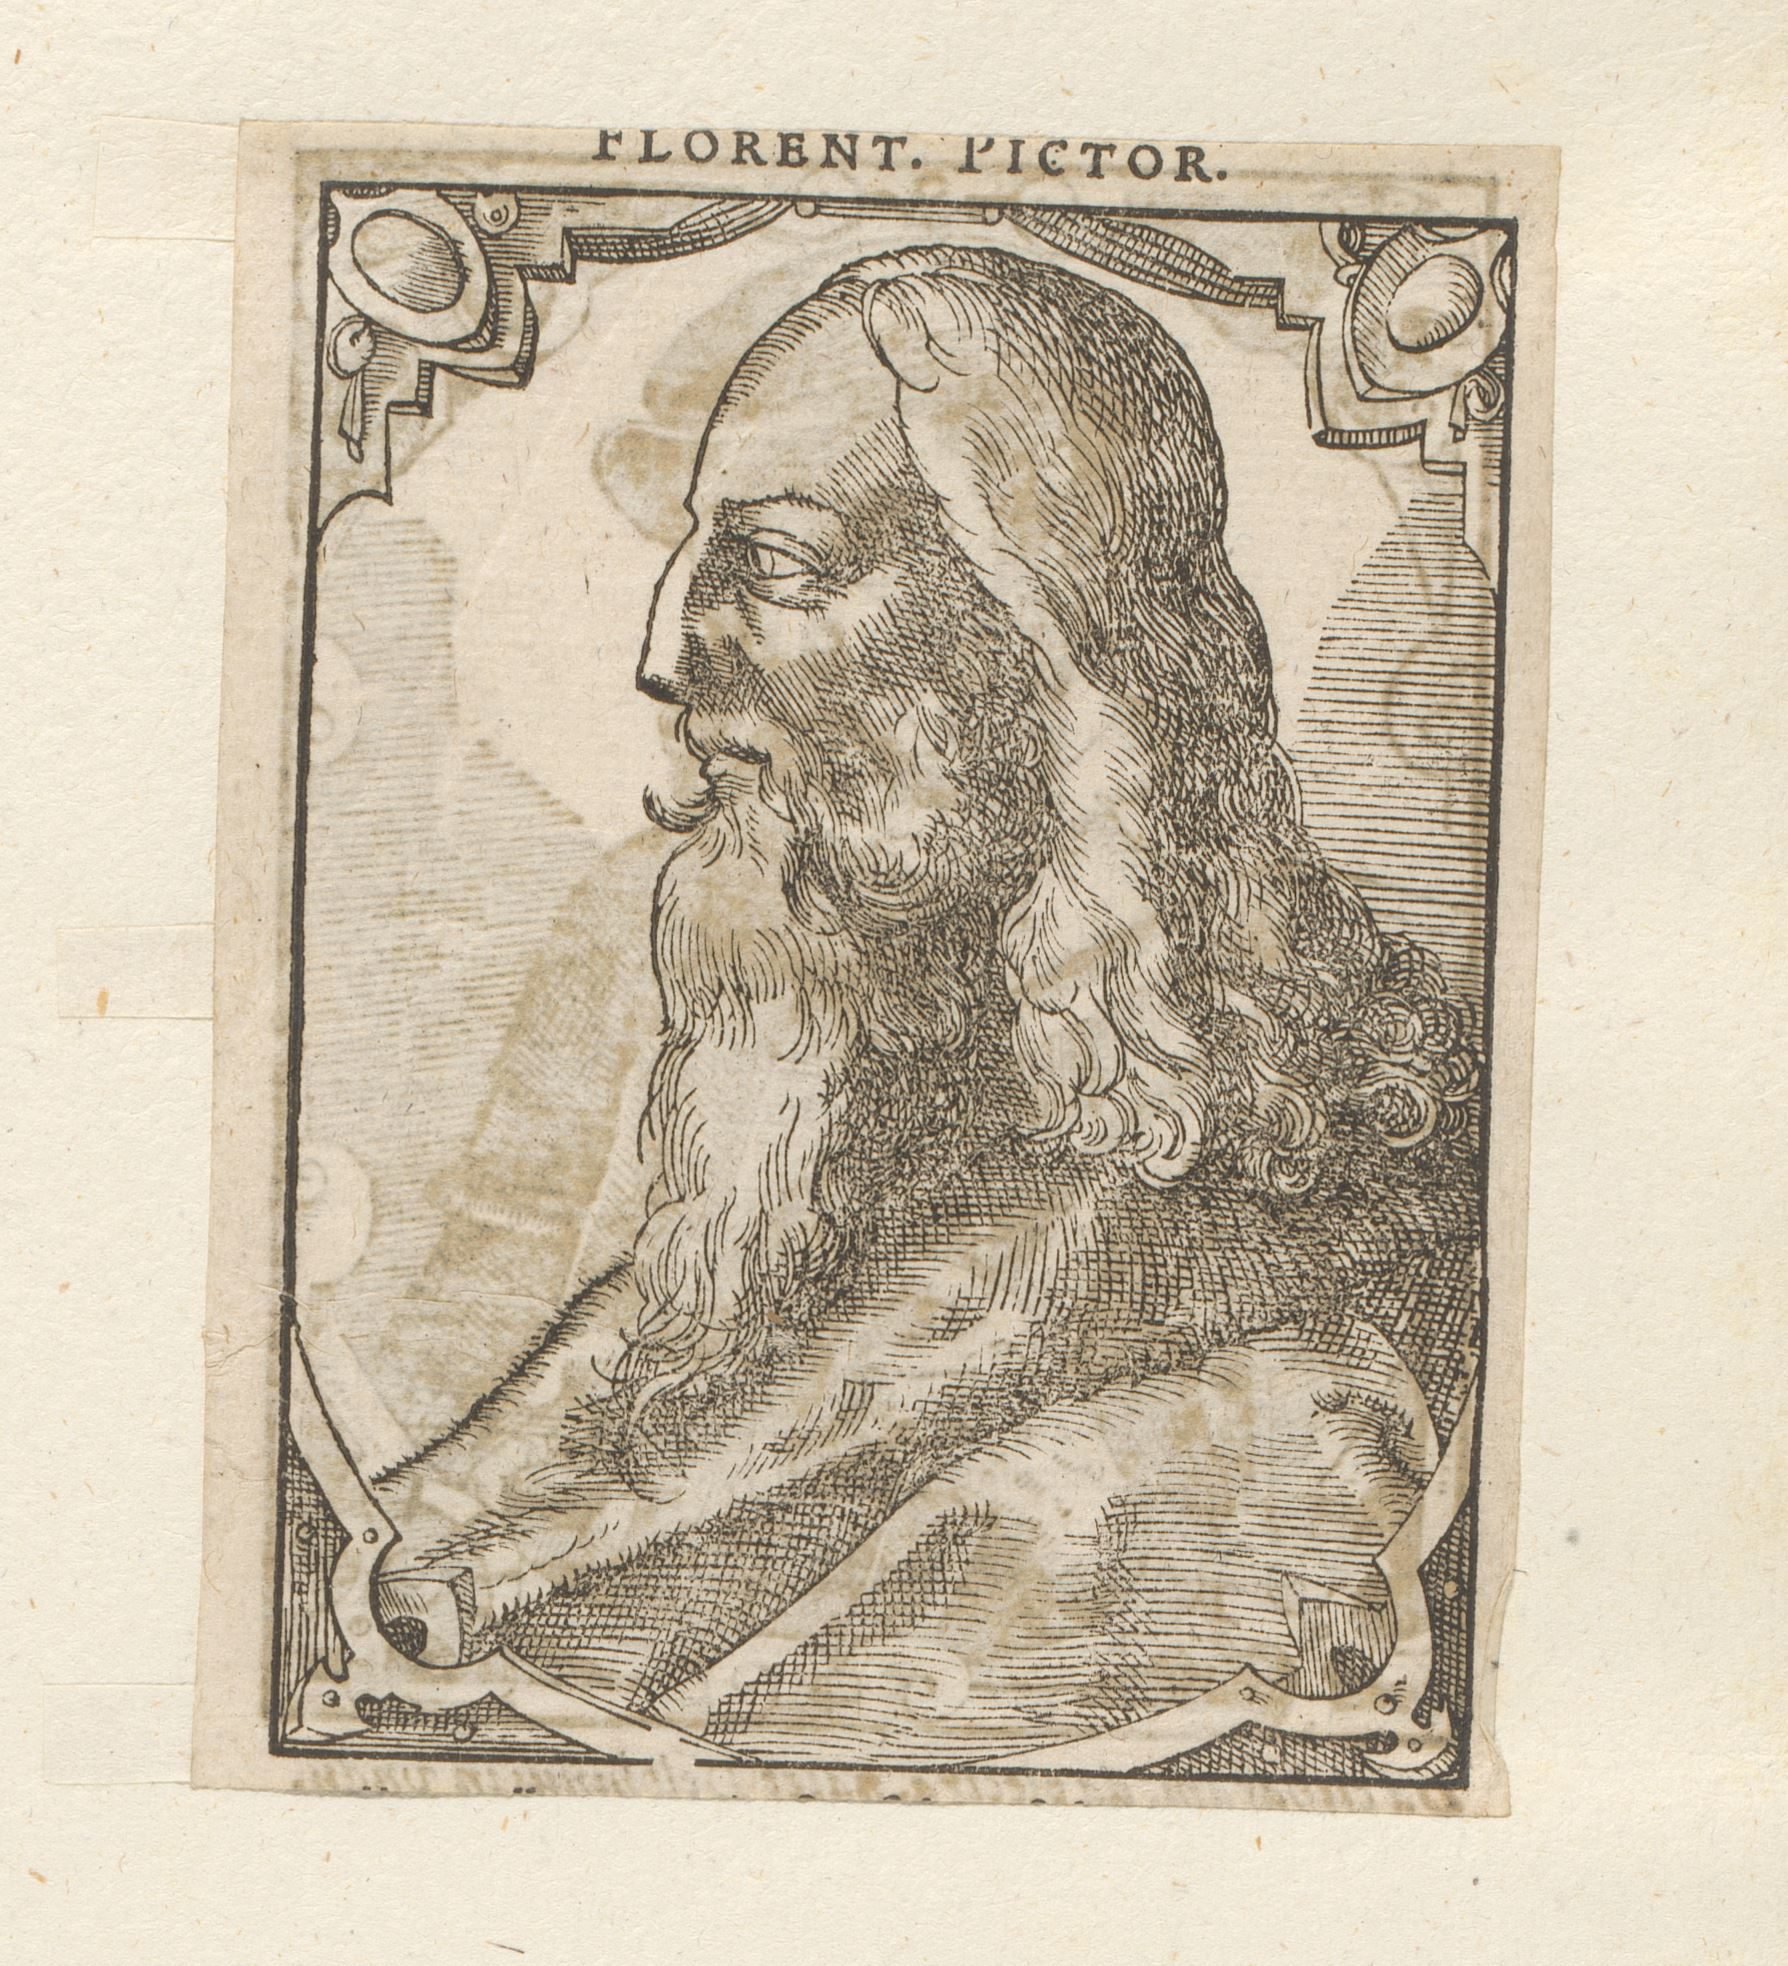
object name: album leaf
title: Portret van Leonardo da Vinci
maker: Anonymous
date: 1549-1584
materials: paper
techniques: woodcut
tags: artist, leonardo da vinci, historical persons, portrait, self-portrait of painter, portrait, self-portrait of graphic artist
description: Prent gebruikt in: Reusner, Nikolaus. Icones Sive Imagines Vivae. Bazel: Conrad Waldkirch, 1589.